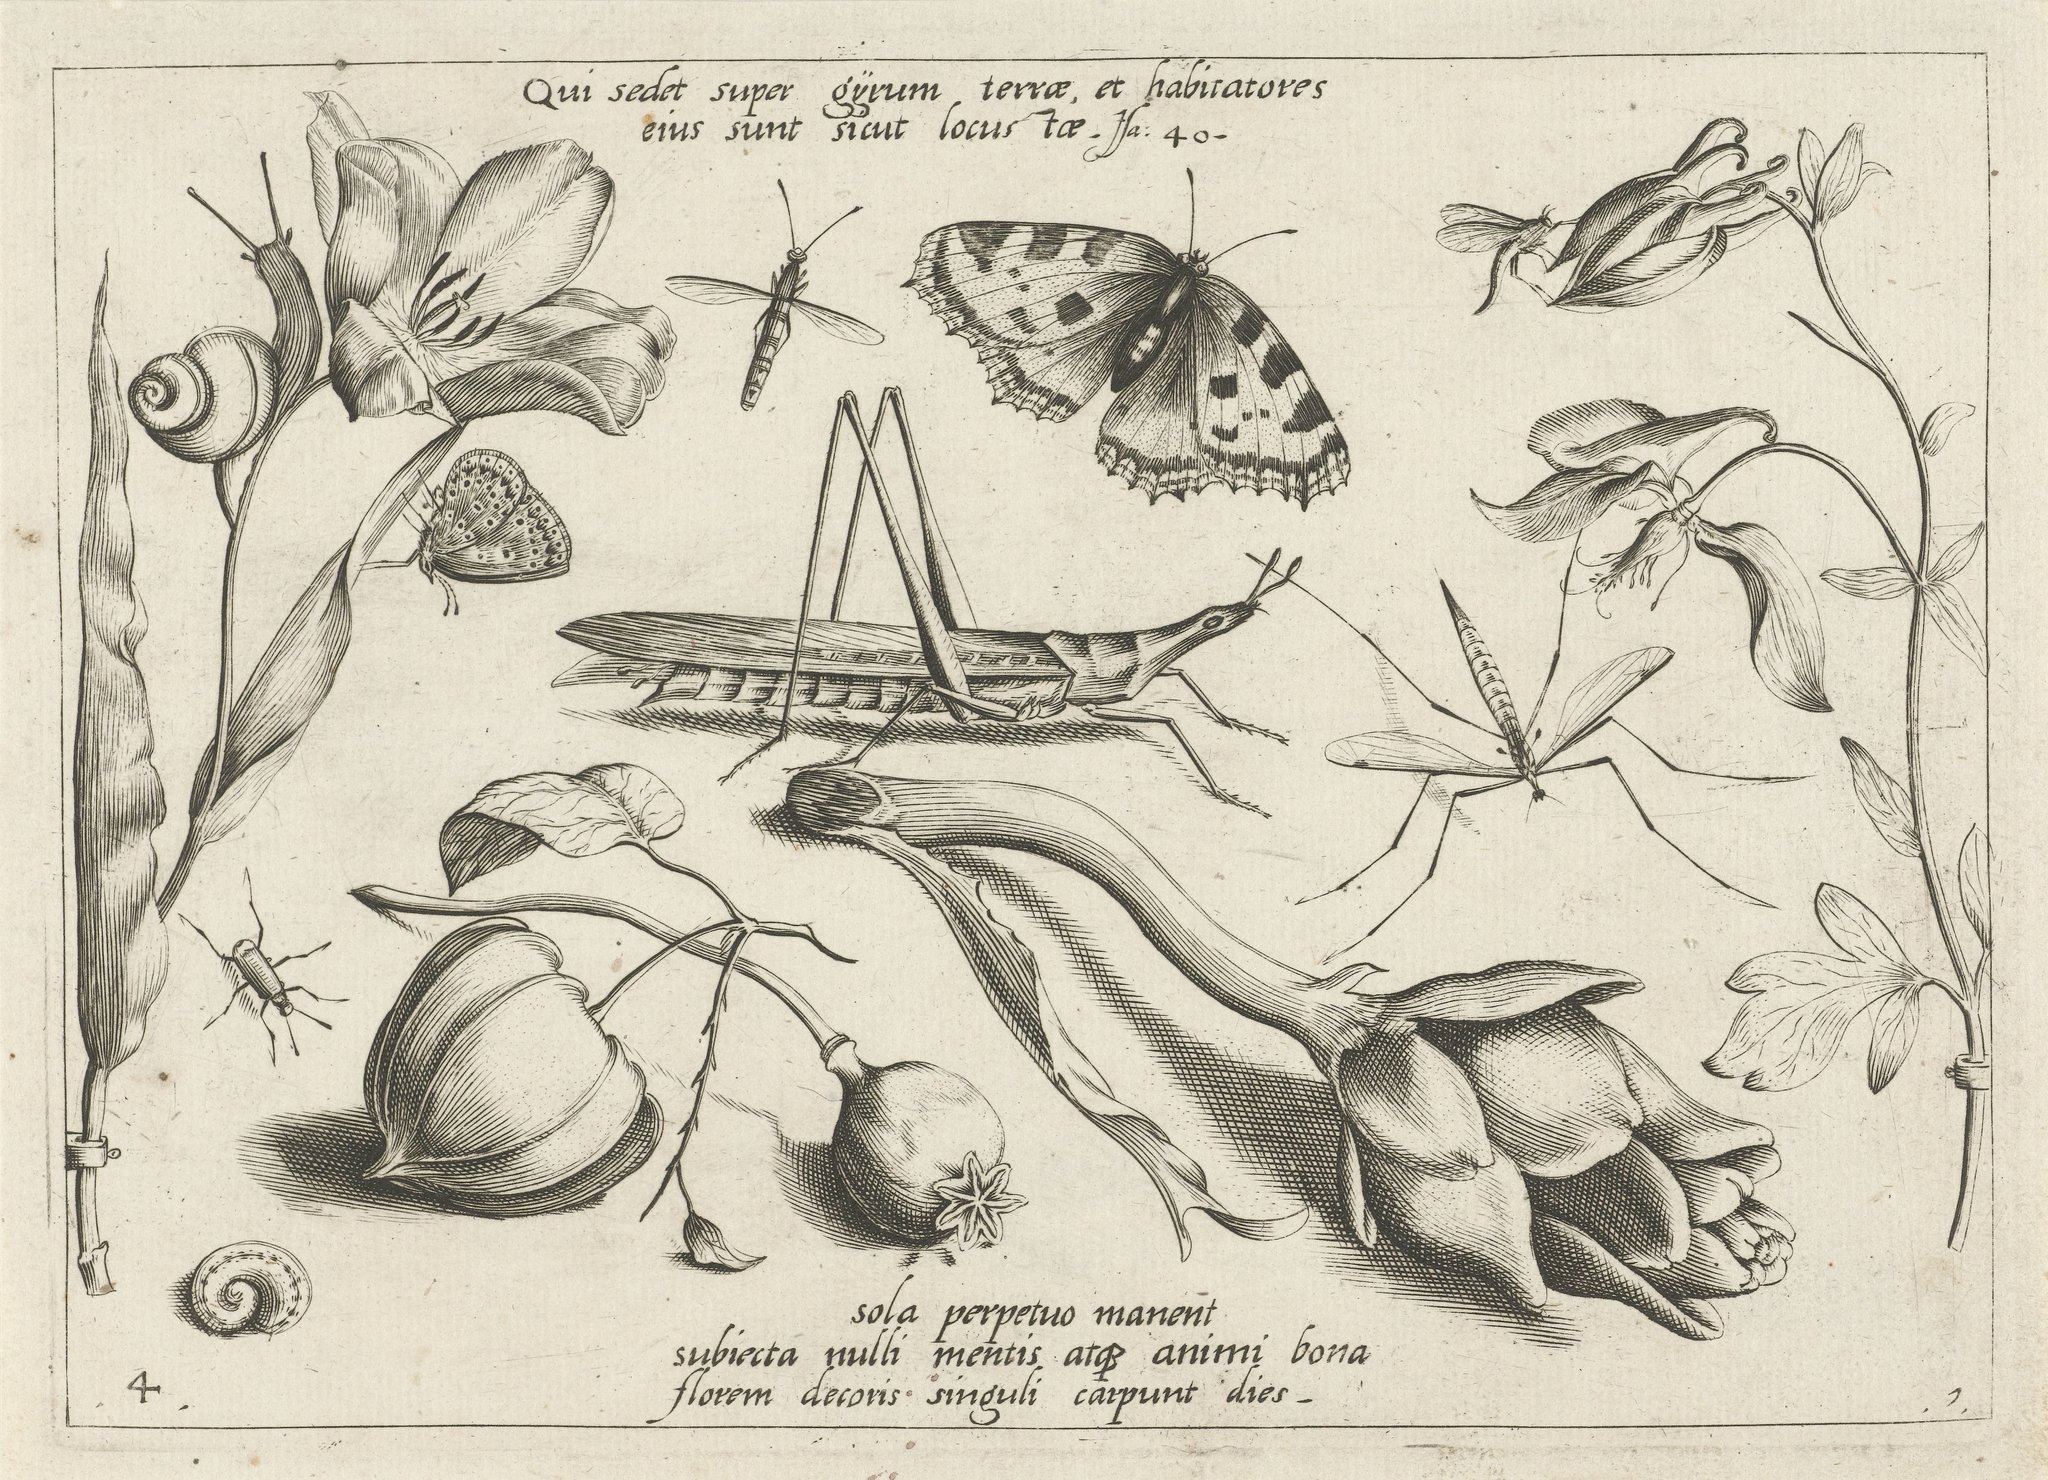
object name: print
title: Insecten, bloemen en vruchten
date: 1592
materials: paper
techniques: engraving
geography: nuremberg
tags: insects: butterfly, molluscs: snail, insects, flowers: poppy, insects: grass-hopper, plants and herbs: artichoke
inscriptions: collector's mark: Lugt 2228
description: Prent uit een serie van 48 prenten, opgedeeld in vier afzonderlijke delen van elk twaalf prenten. Rechtsonder vermeld: [deel] 1. Boven- en onderaan een tekst in het Latijn.